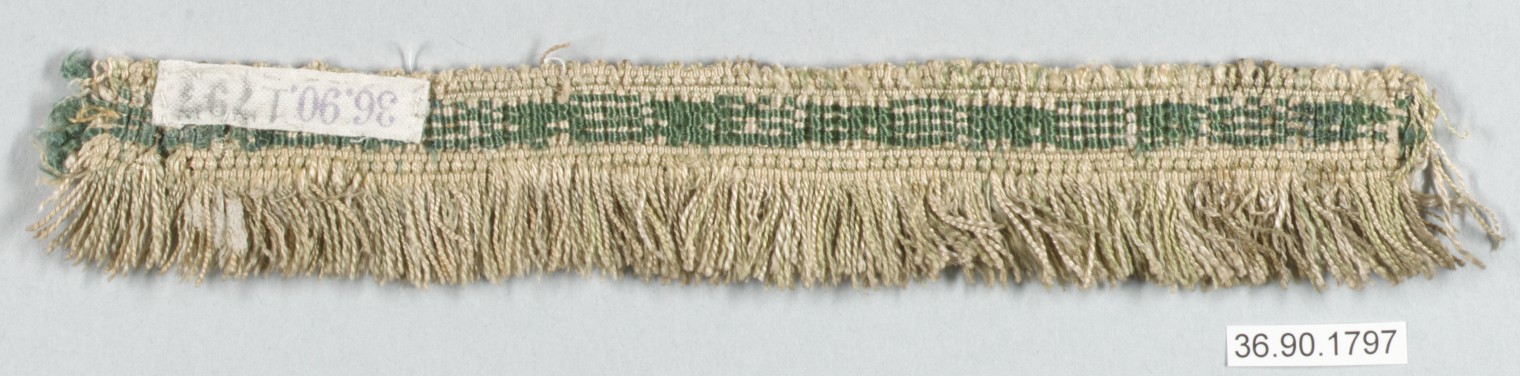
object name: piece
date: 1734-1766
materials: silk